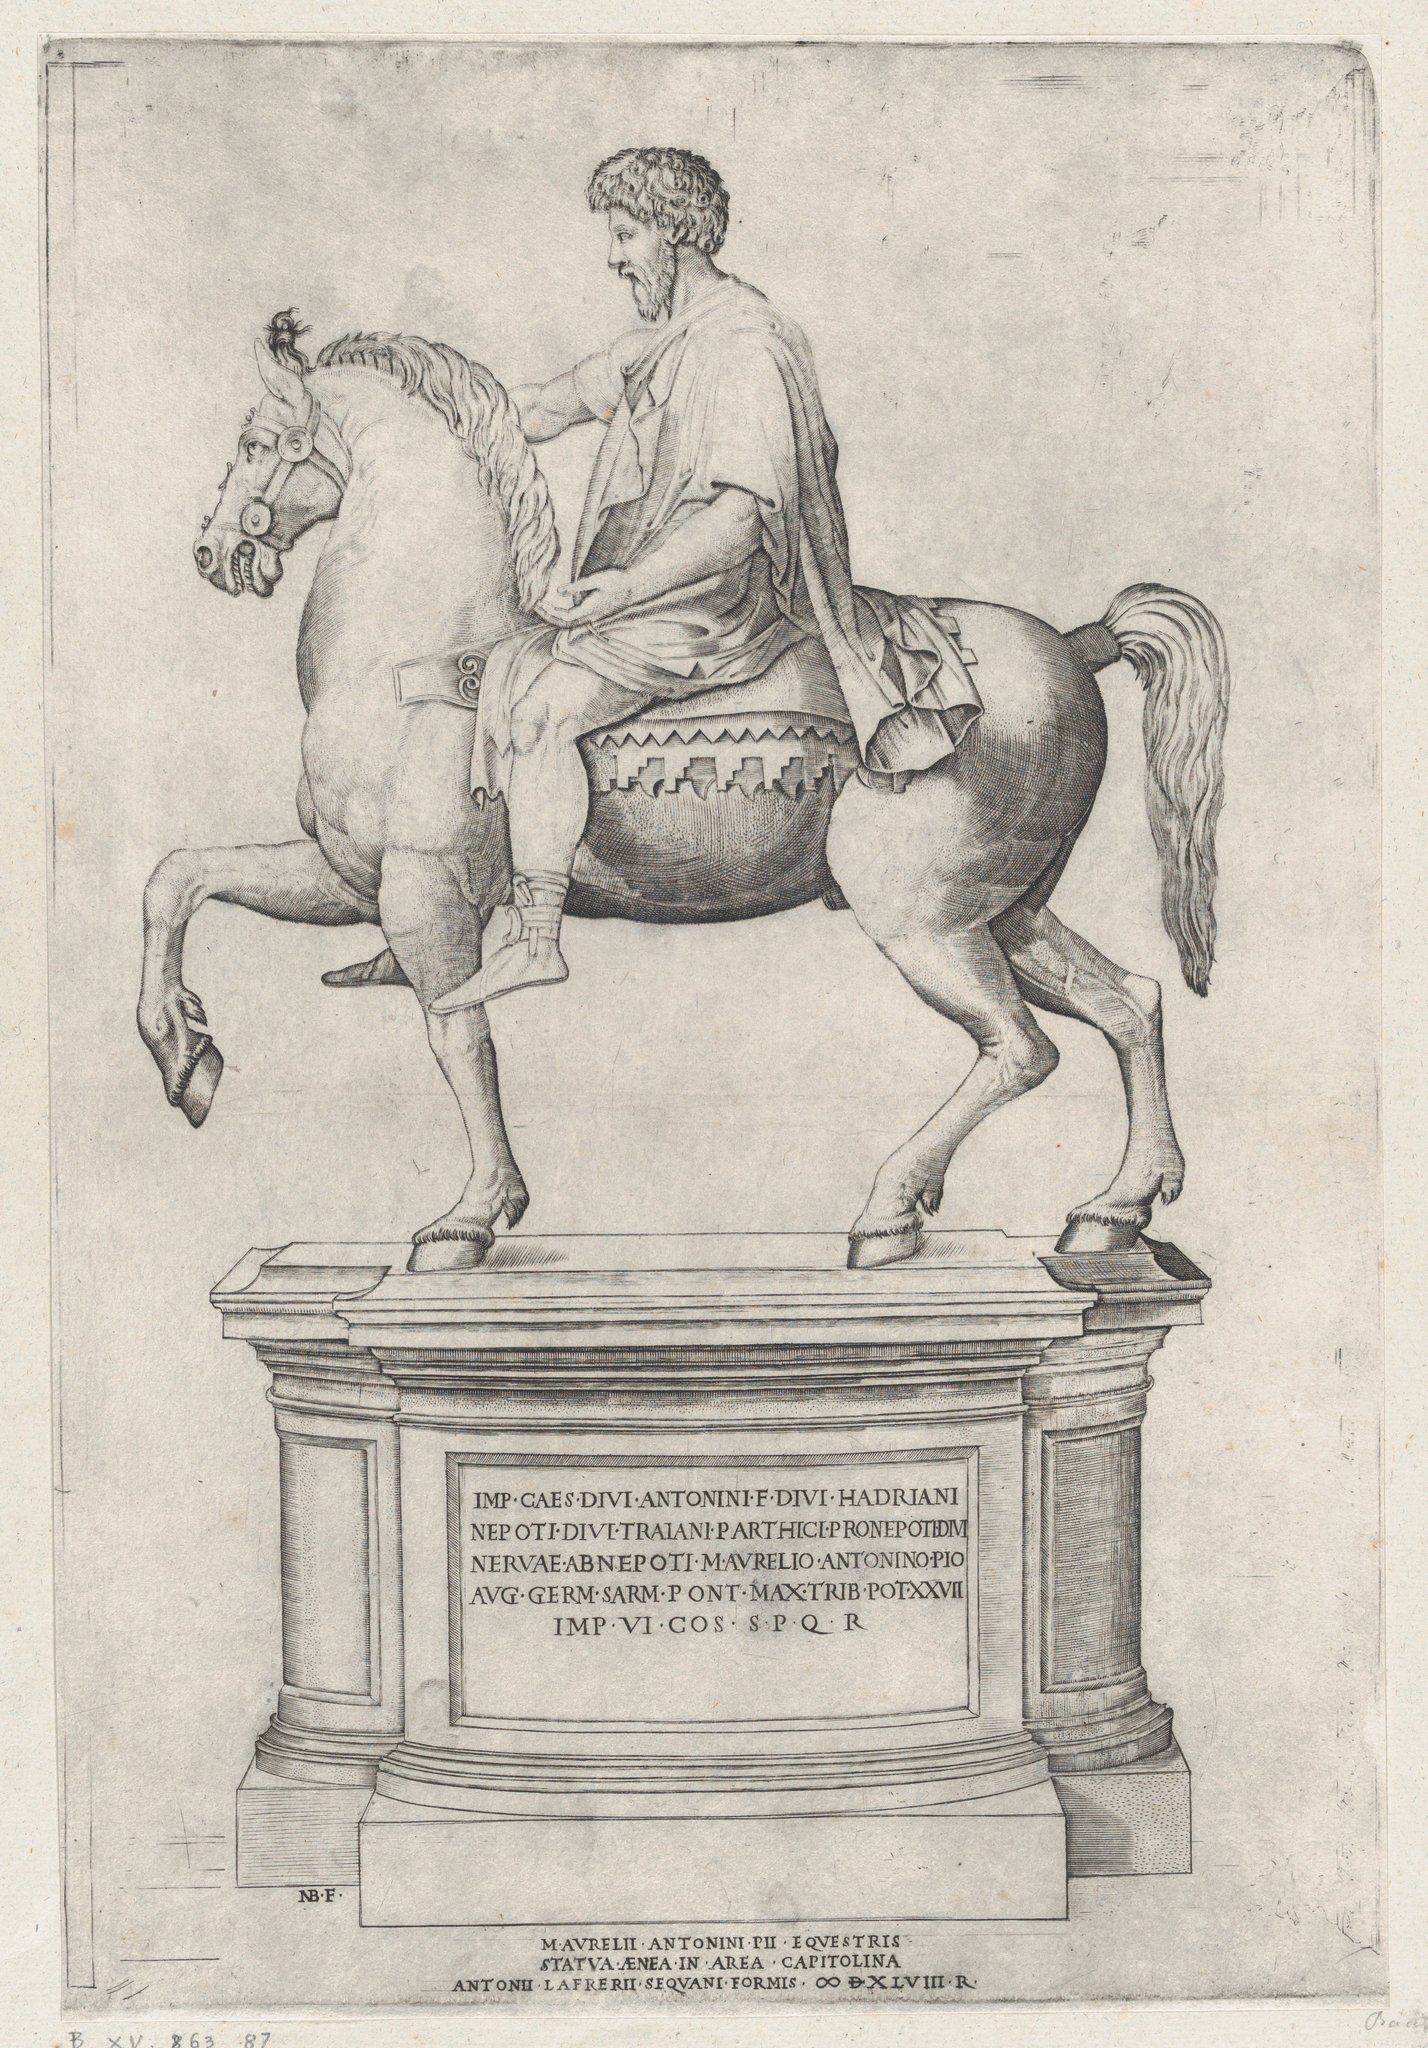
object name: print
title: The Equestrian Statue of Marcus Aurelius on the Capitol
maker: nicolas beatrizet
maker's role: artist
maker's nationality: french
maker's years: 1515-1566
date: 1548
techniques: engraving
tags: men,profiles,horses